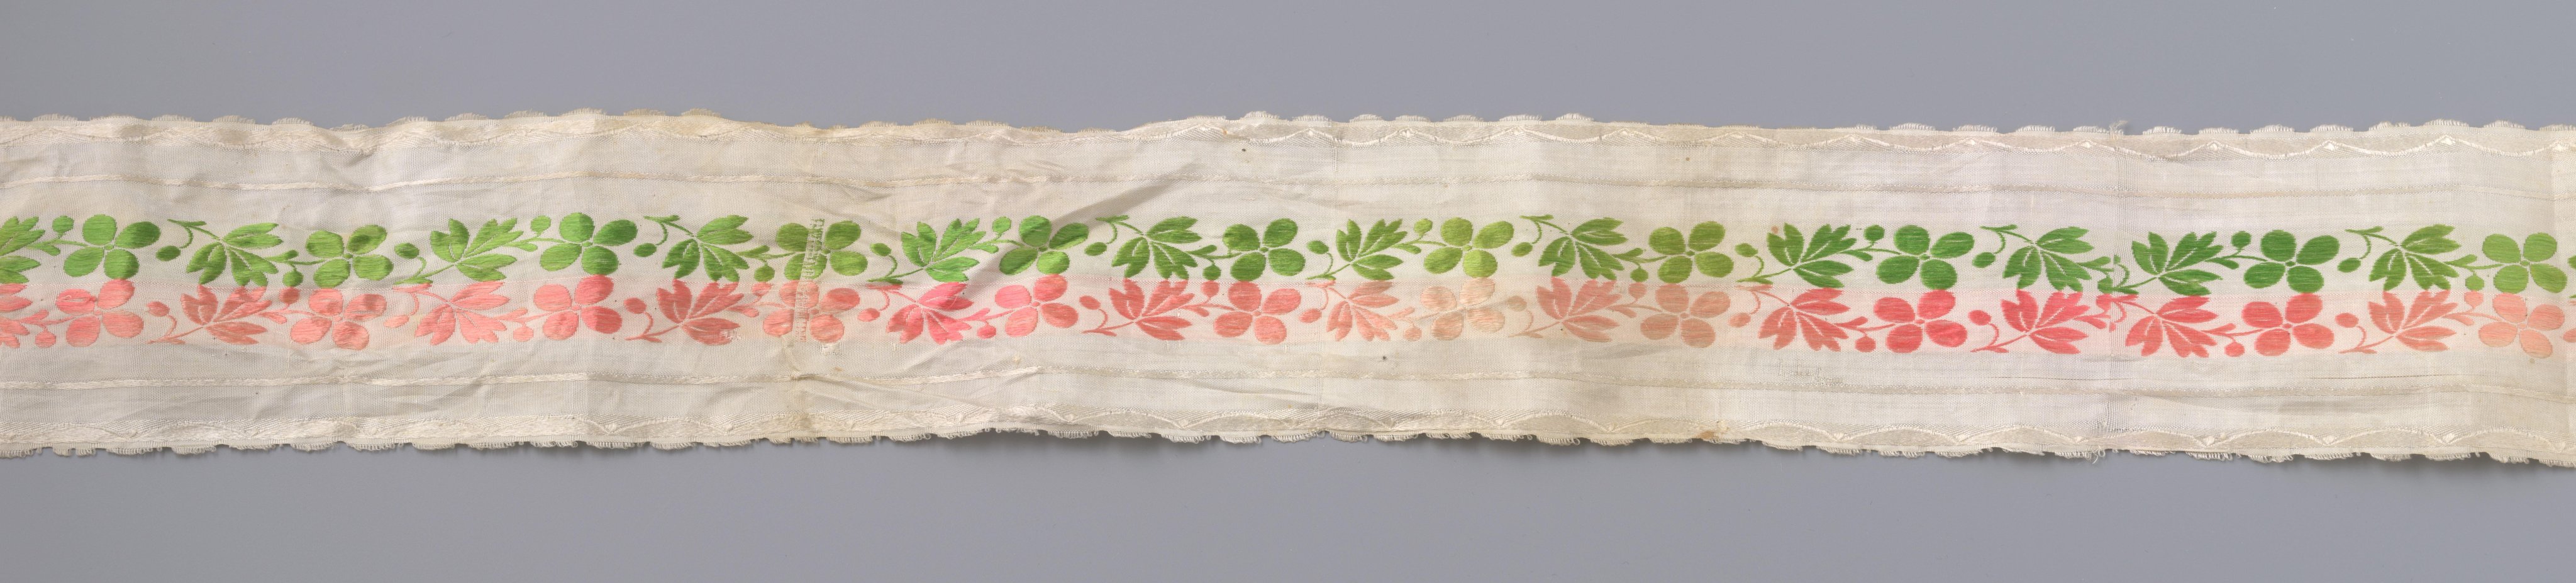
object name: ribbon material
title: Lint van gebrocheerde zijde met een roomkleurige ondergrond waarop over de gehele lengte een naast elkaar gelegen roze en groene bloem- en bladrank zijn aangebracht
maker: Anonymous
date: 1800-1815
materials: silk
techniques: brocade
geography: western europe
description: Lint van gebrocheerde zijde met een roomkleurige ondergrond waarop over de gehele lengte een naast elkaar gelegen roze en groene bloem- en bladrank zijn aangebracht. De randen zijn geschulpt.